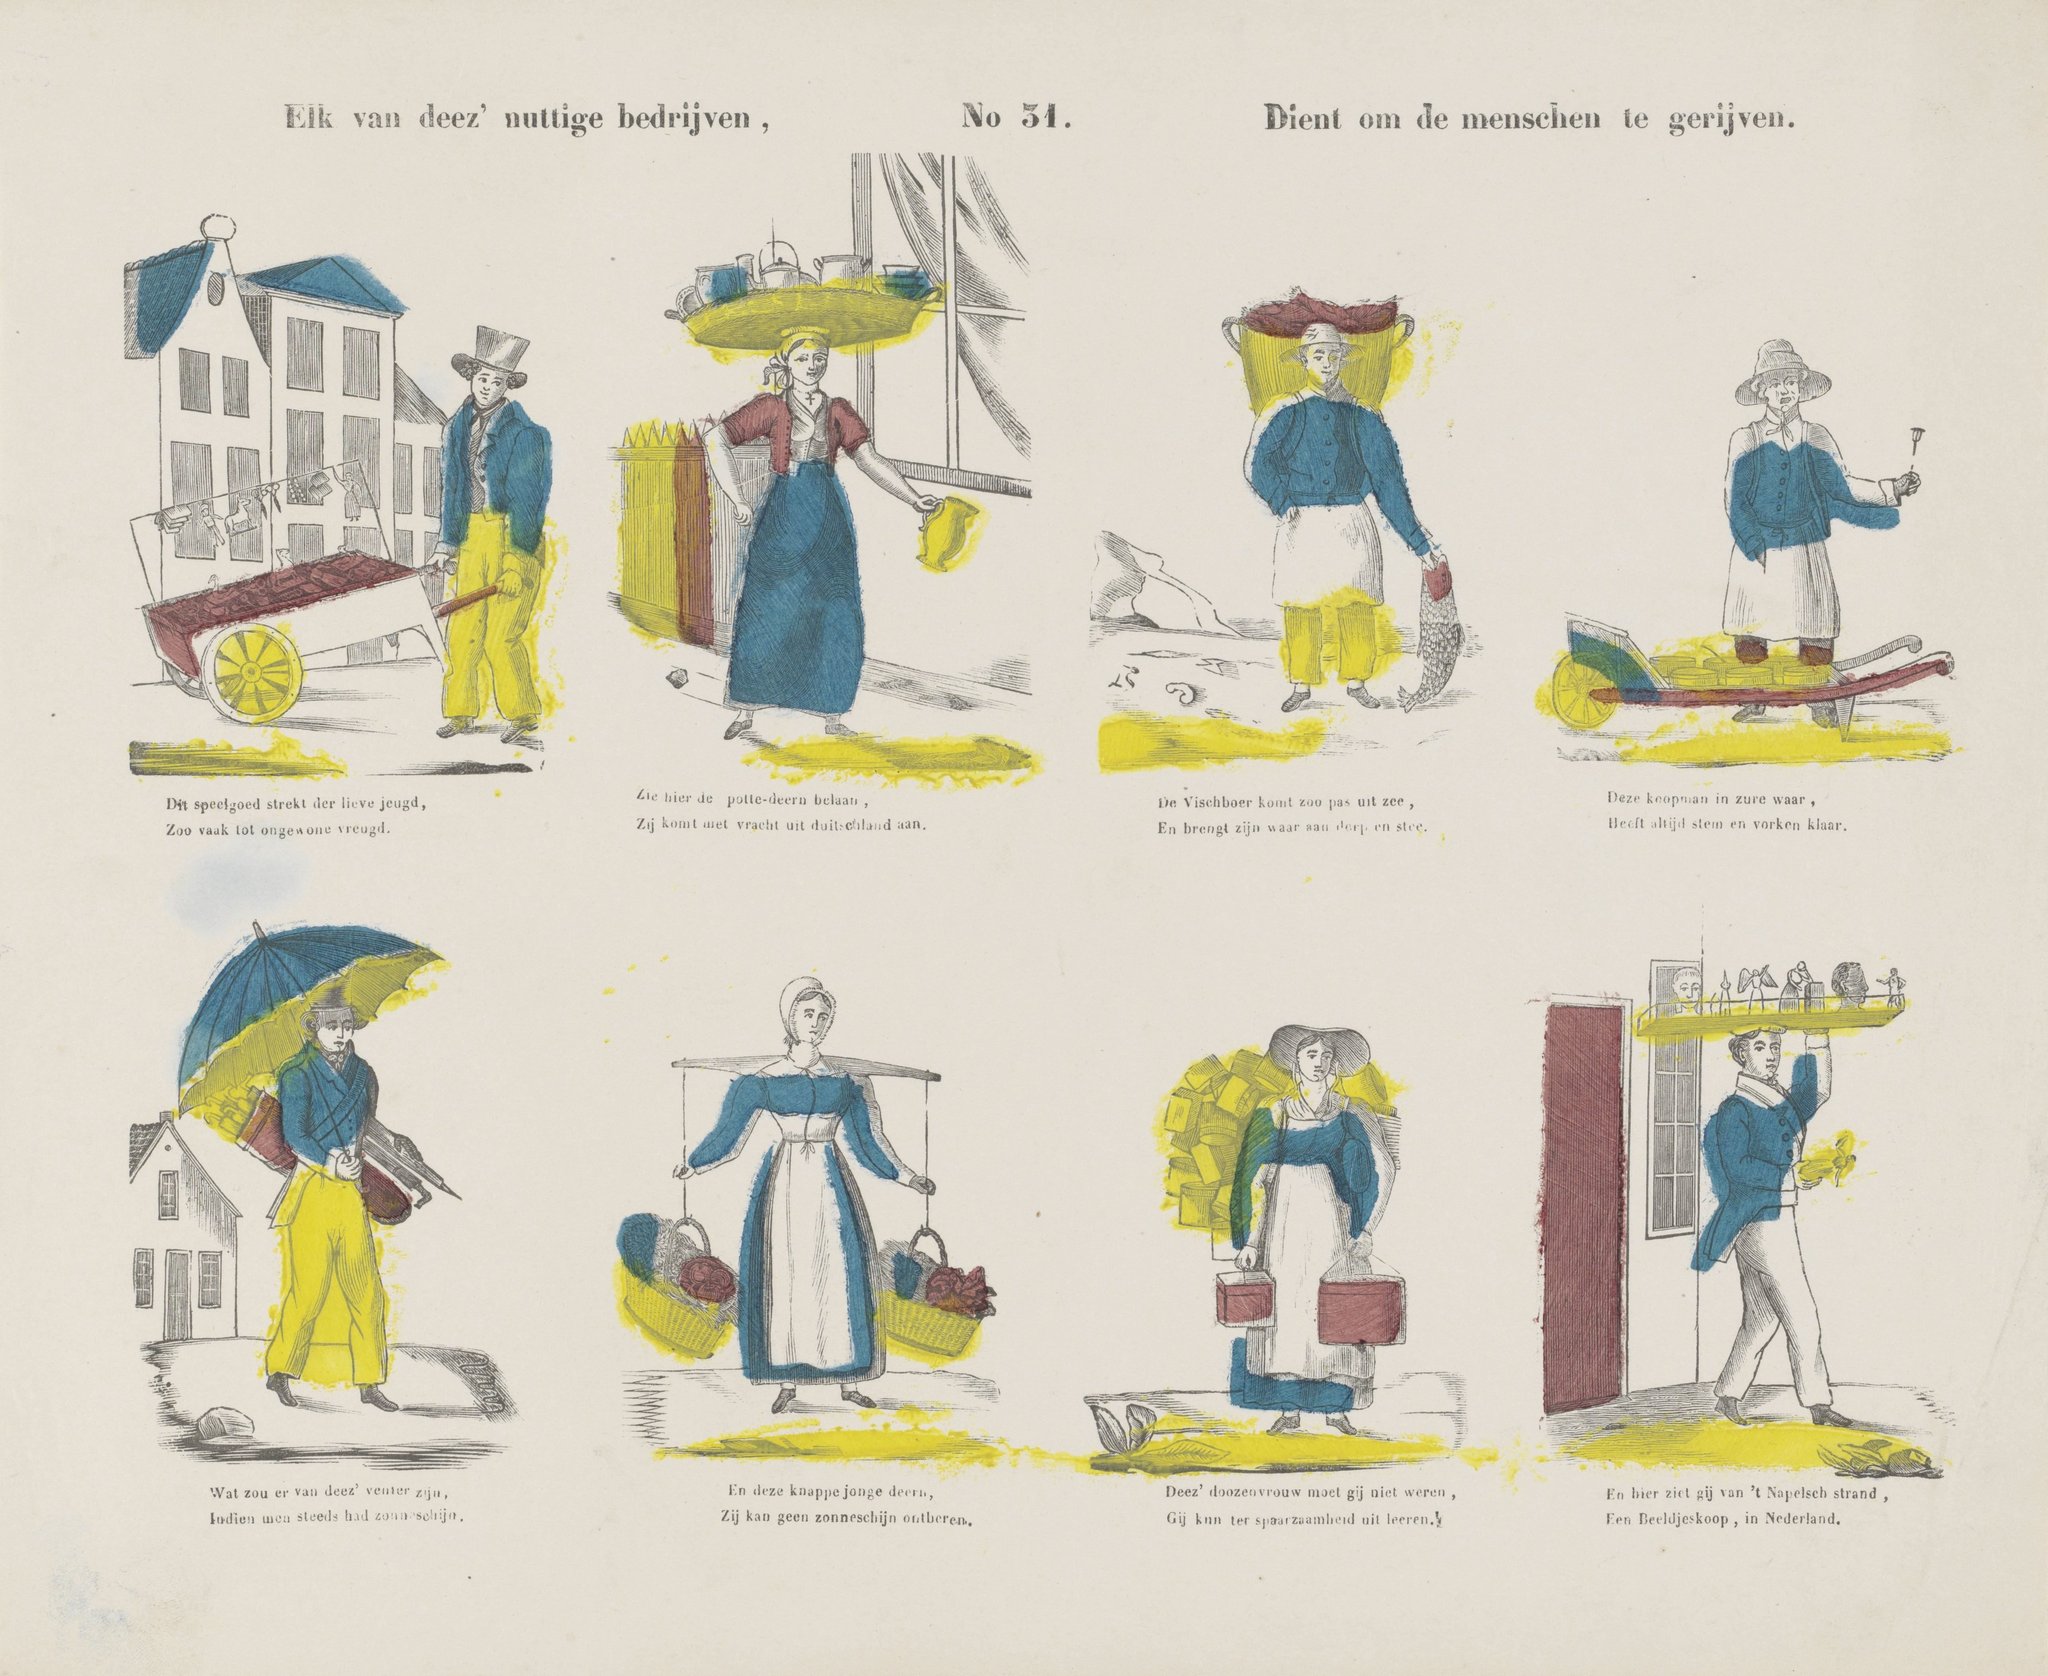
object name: popular print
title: Elk van deez' nuttige bedrijven / Dient om de menschen te gerijven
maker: Anonymous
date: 1848-1881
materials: paper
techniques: colour, letterpress printing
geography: netherlands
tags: street-trader, merchant, salesman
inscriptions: collector's mark: Lugt 2760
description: Blad met 8 voorstellingen van straatverkopers. Onder elke afbeelding een tweeregelig vers. Genummerd midden boven: No 31.